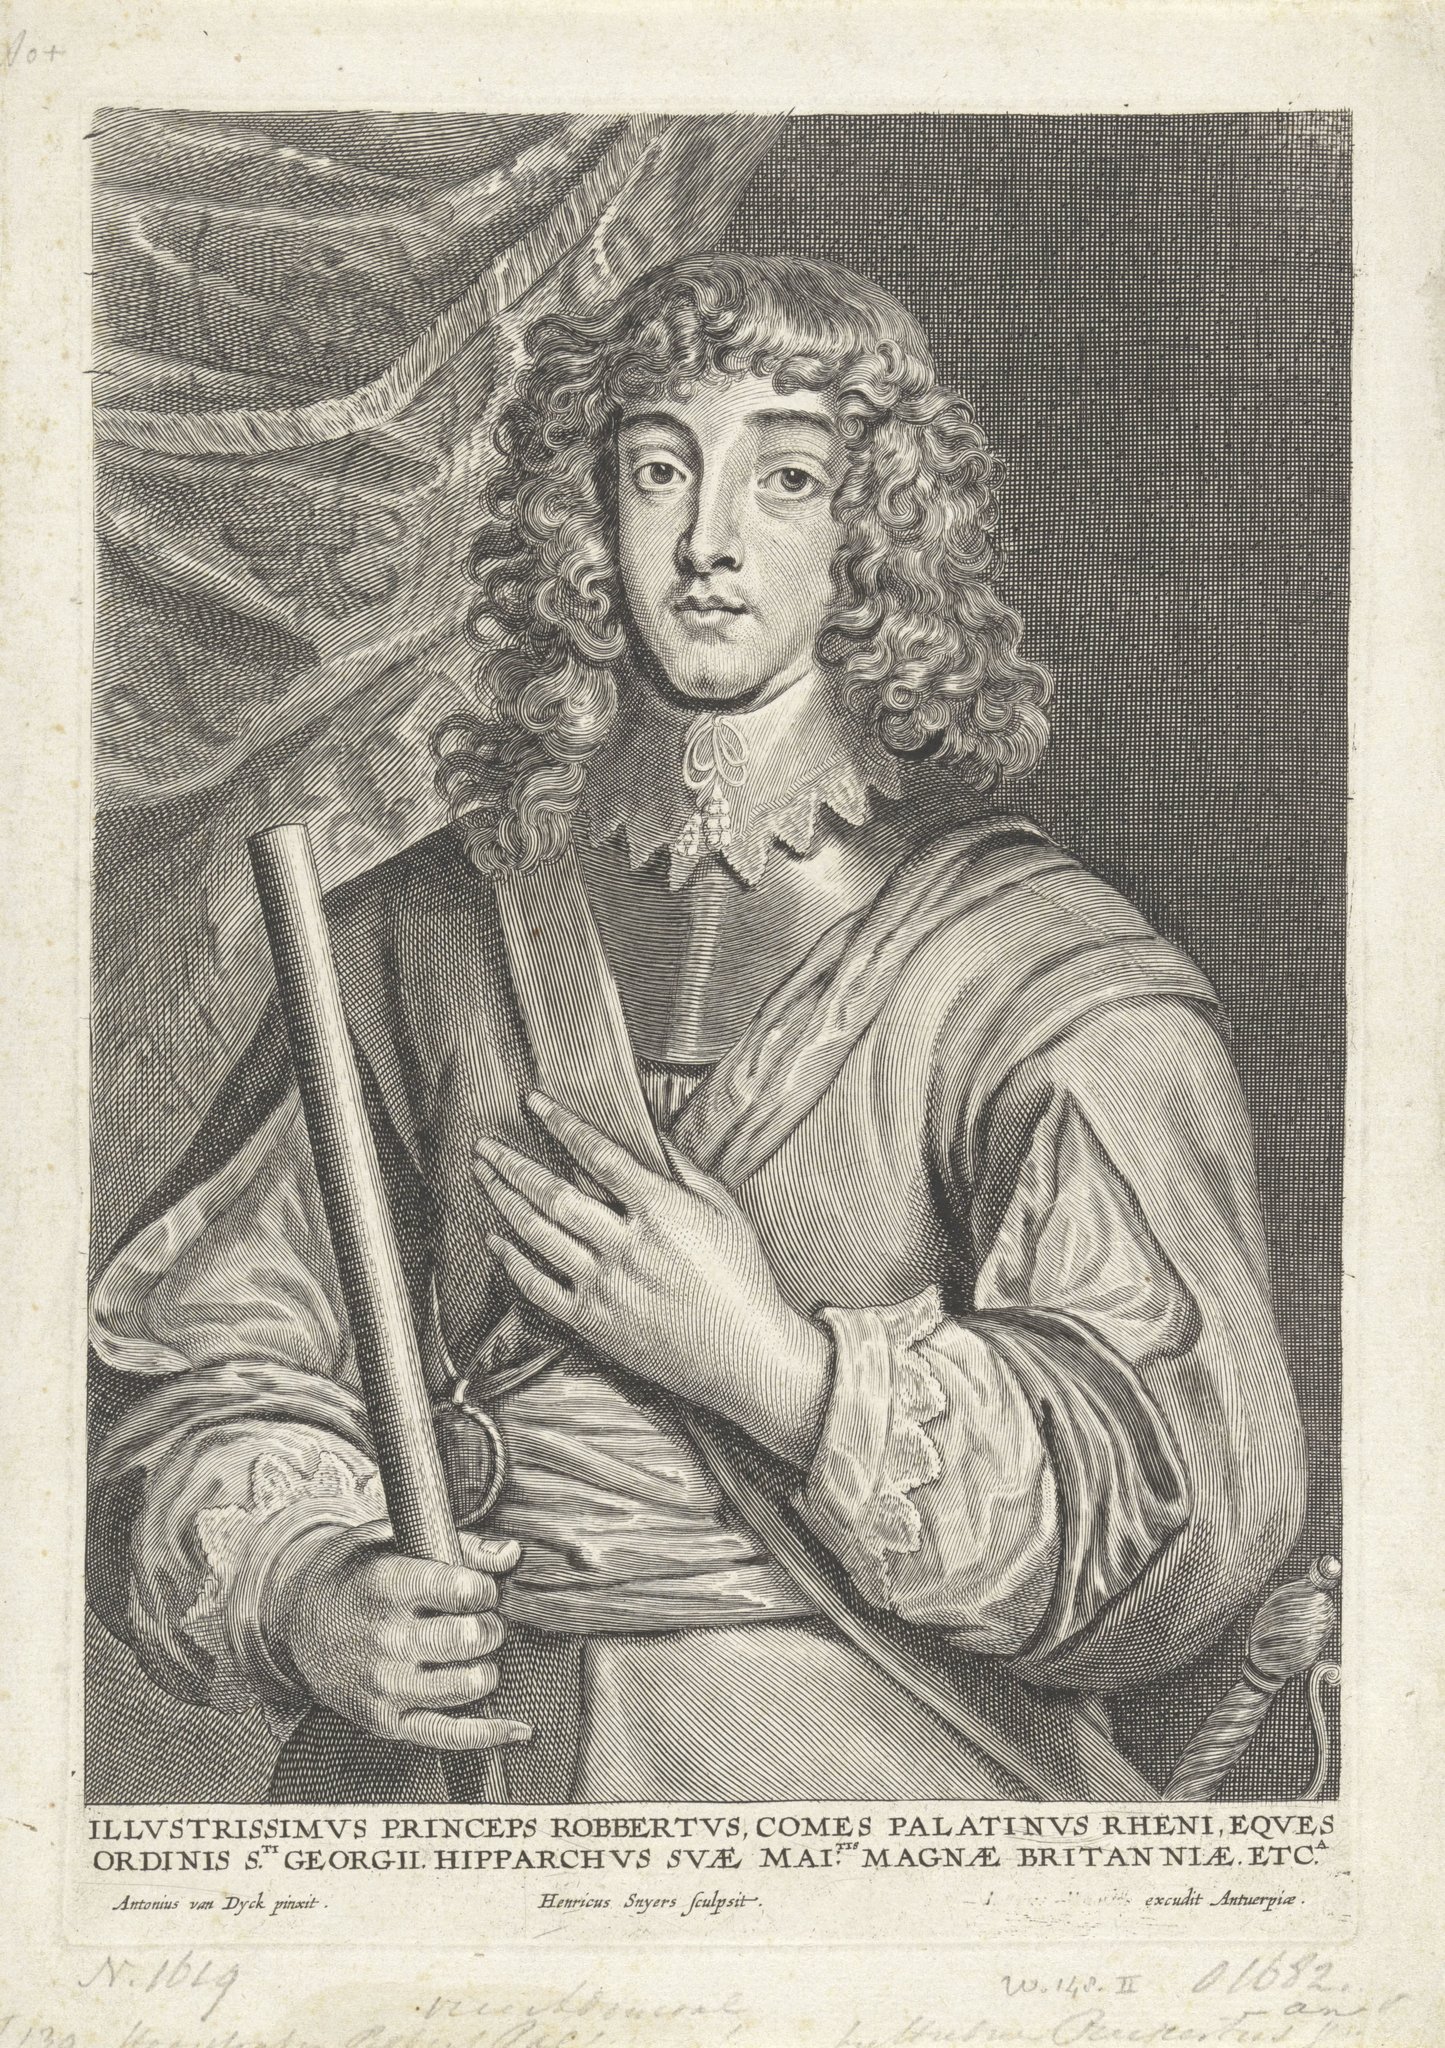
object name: print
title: Portret van Prins Ruprecht van de Palts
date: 1728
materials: paper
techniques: engraving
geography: the hague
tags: painter, print maker, draughtsman, prinz ruprecht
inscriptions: collector's mark: Lugt 2760, collector's mark: Lugt 2228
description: Prent komt voor in: De konst-kamer der allerschoonste portraitten van verscheide prinsen en prinsessen (...). Geschildert door (...) Antoni van Dyck. Den Haag: Rutger Christoffel Alberts en Isaac van der Kloot, 1728.